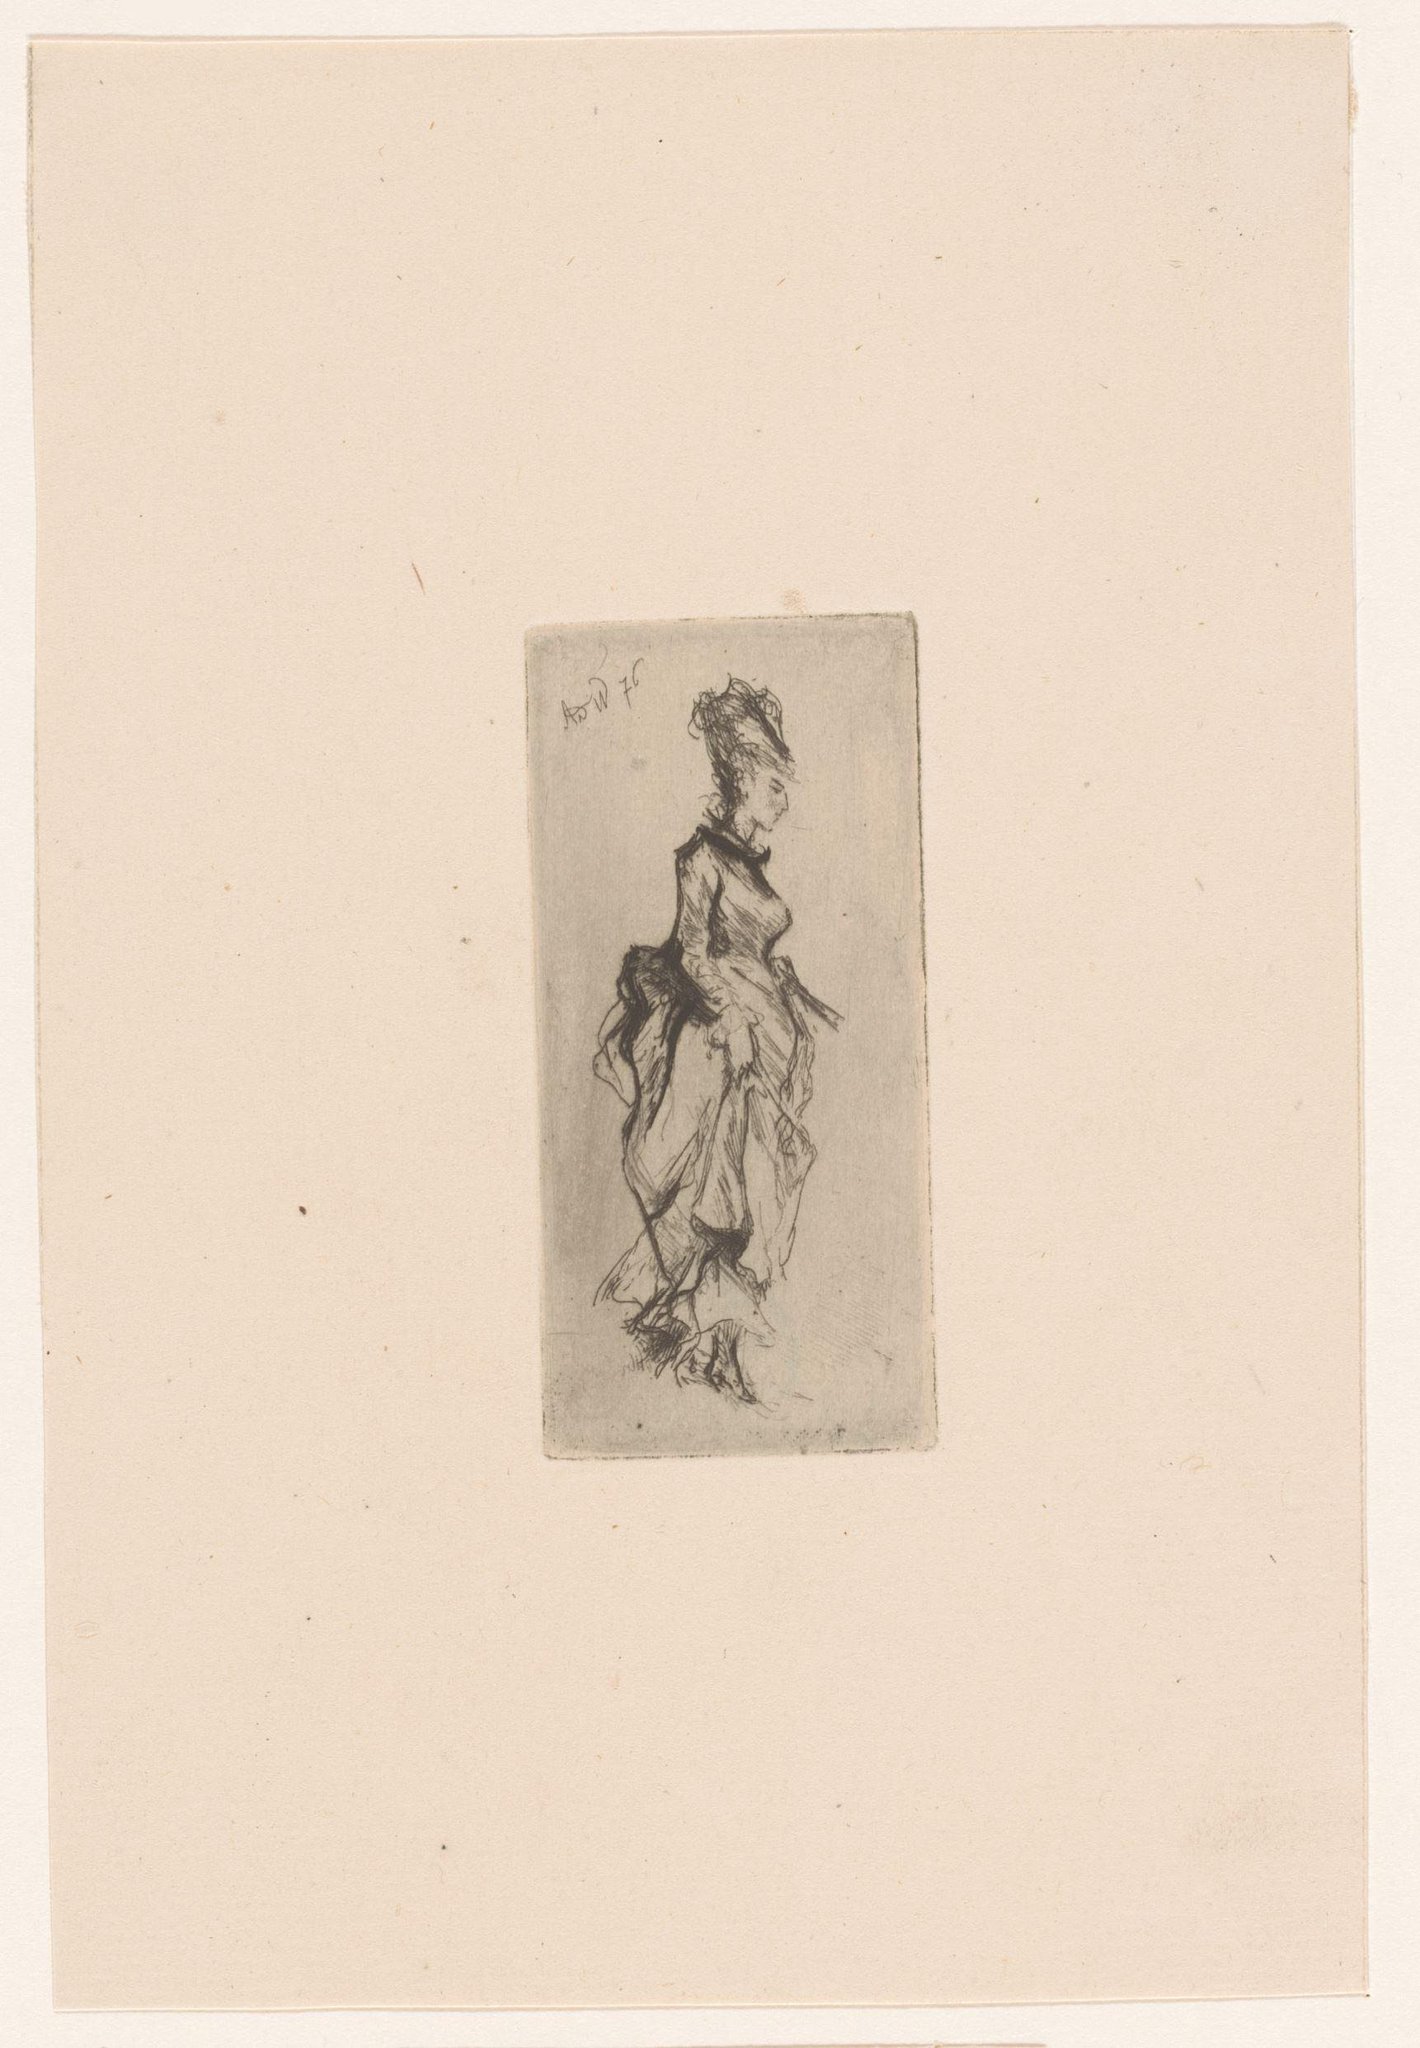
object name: print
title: Vrouw tilt de onderkant van haar jurk op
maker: adrien de witte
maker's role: print maker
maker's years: 1850-1935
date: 1876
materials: paper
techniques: etching, intaglio, retroussage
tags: adult woman, dress, gown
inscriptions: collector's mark: Lugt 2228